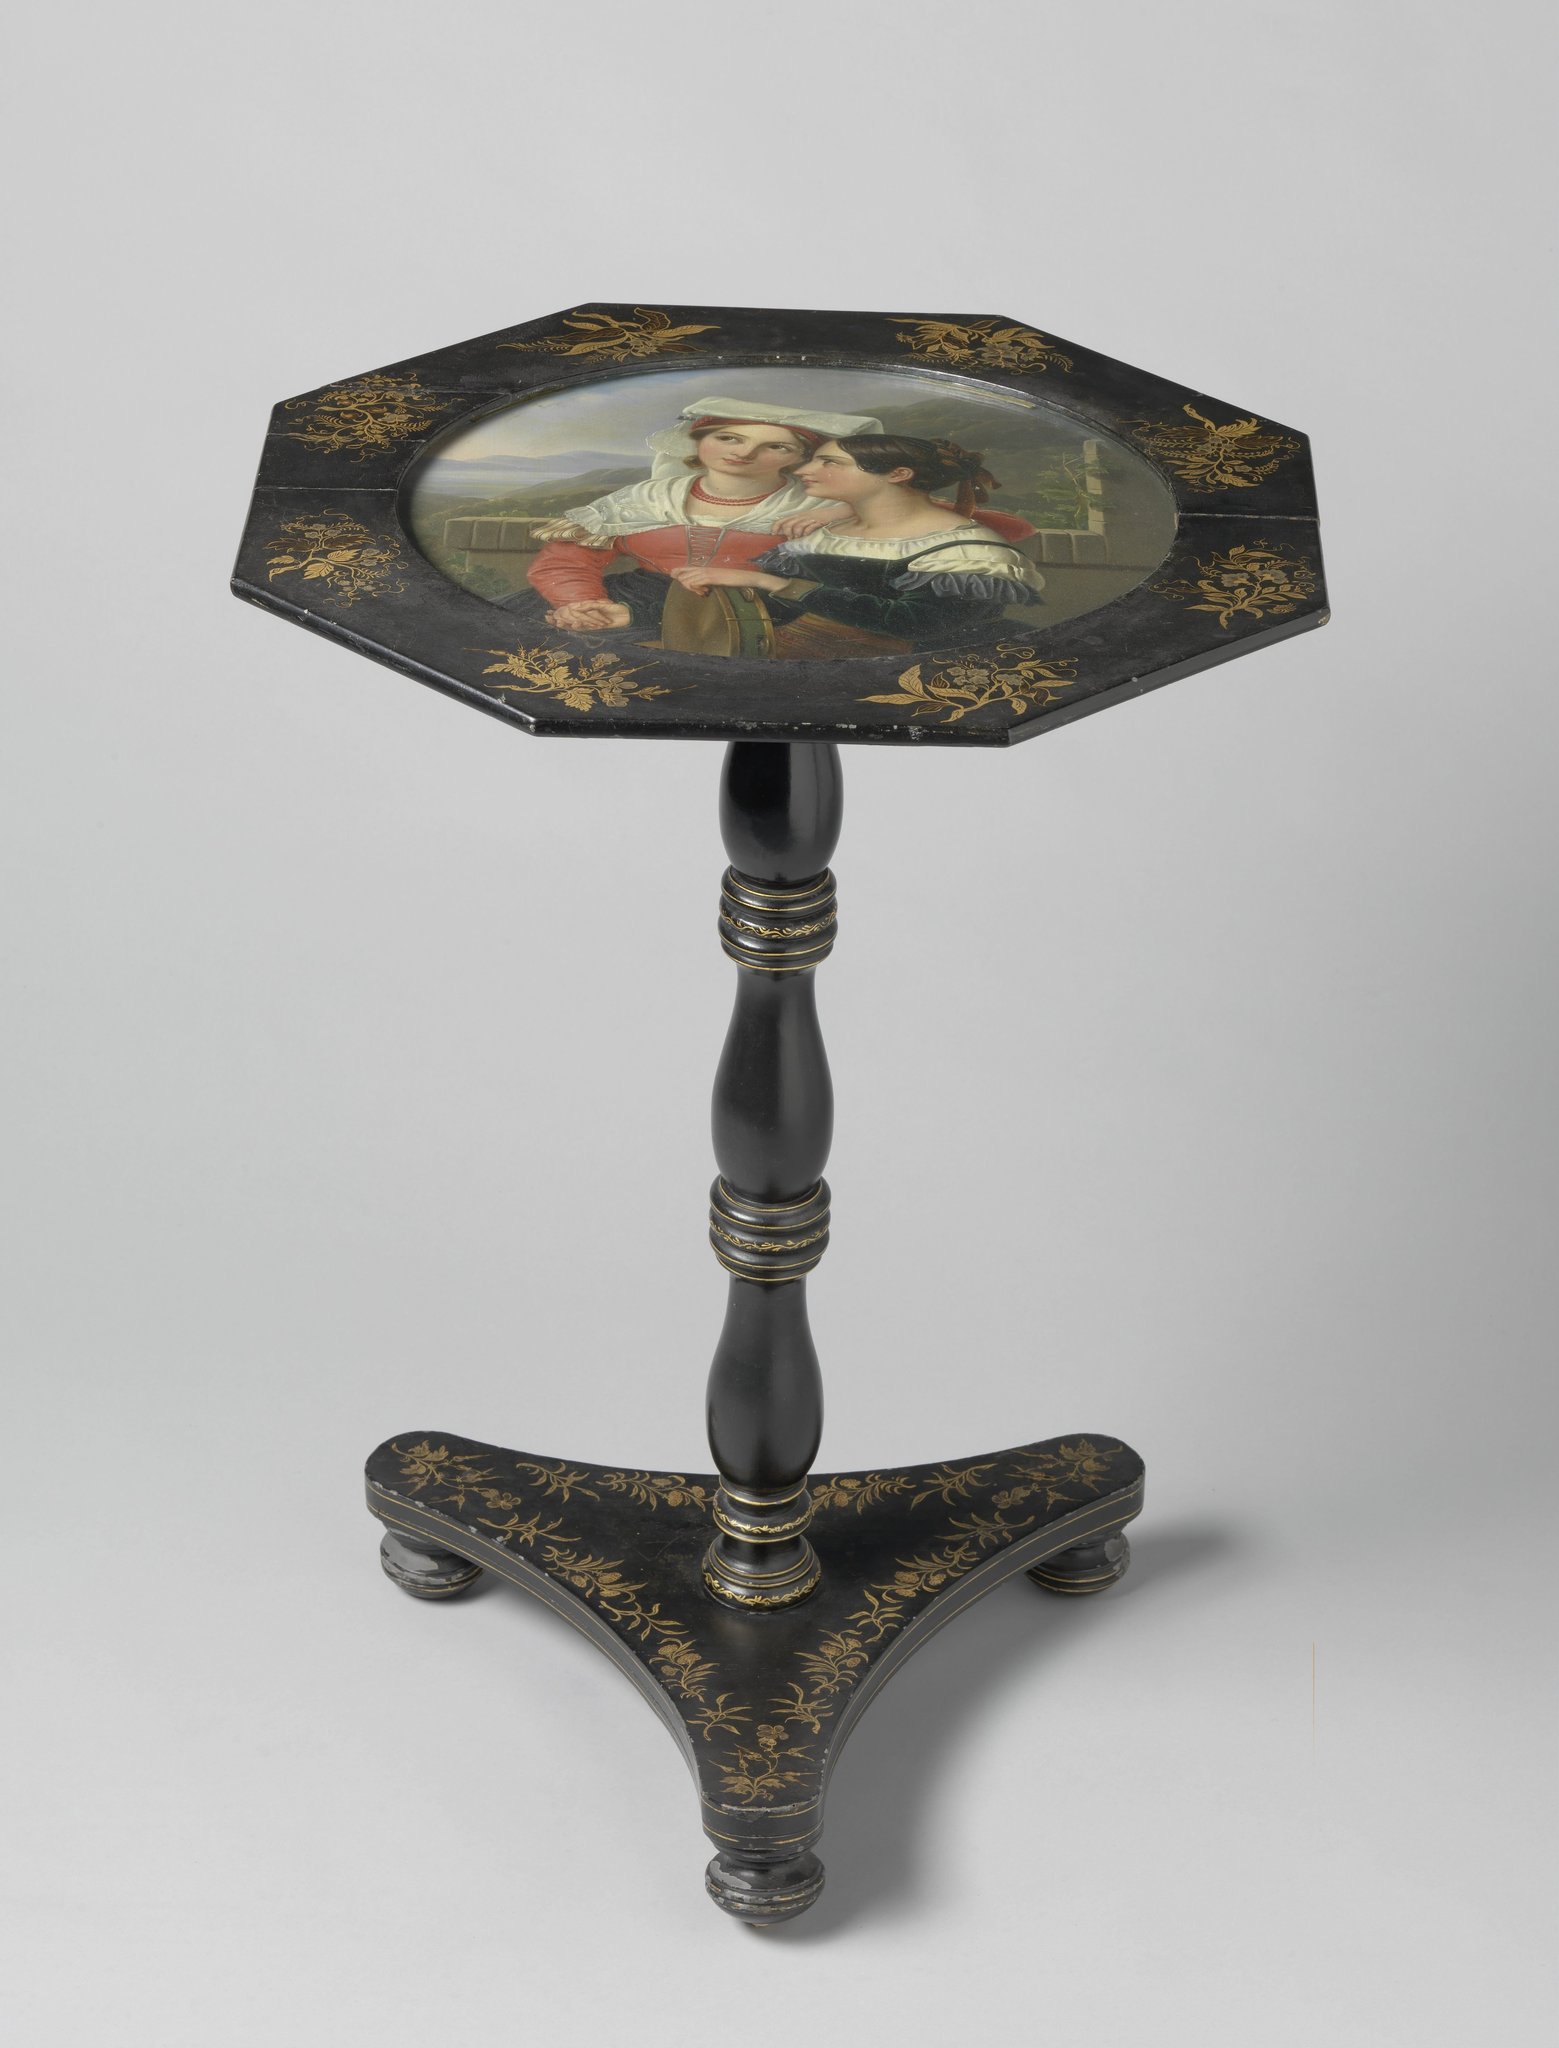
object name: table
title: Tafel met opklapbaar blad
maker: Anonymous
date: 1830-1845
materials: oil, paint, wood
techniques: lacquer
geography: netherlands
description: Tafel, gelakt in Japanse stijl, ingelegd met ronde schildering van twee vrouwen naar het schilderij van Cornelis Kruseman, 'Een van zin' (SK-A-1070).